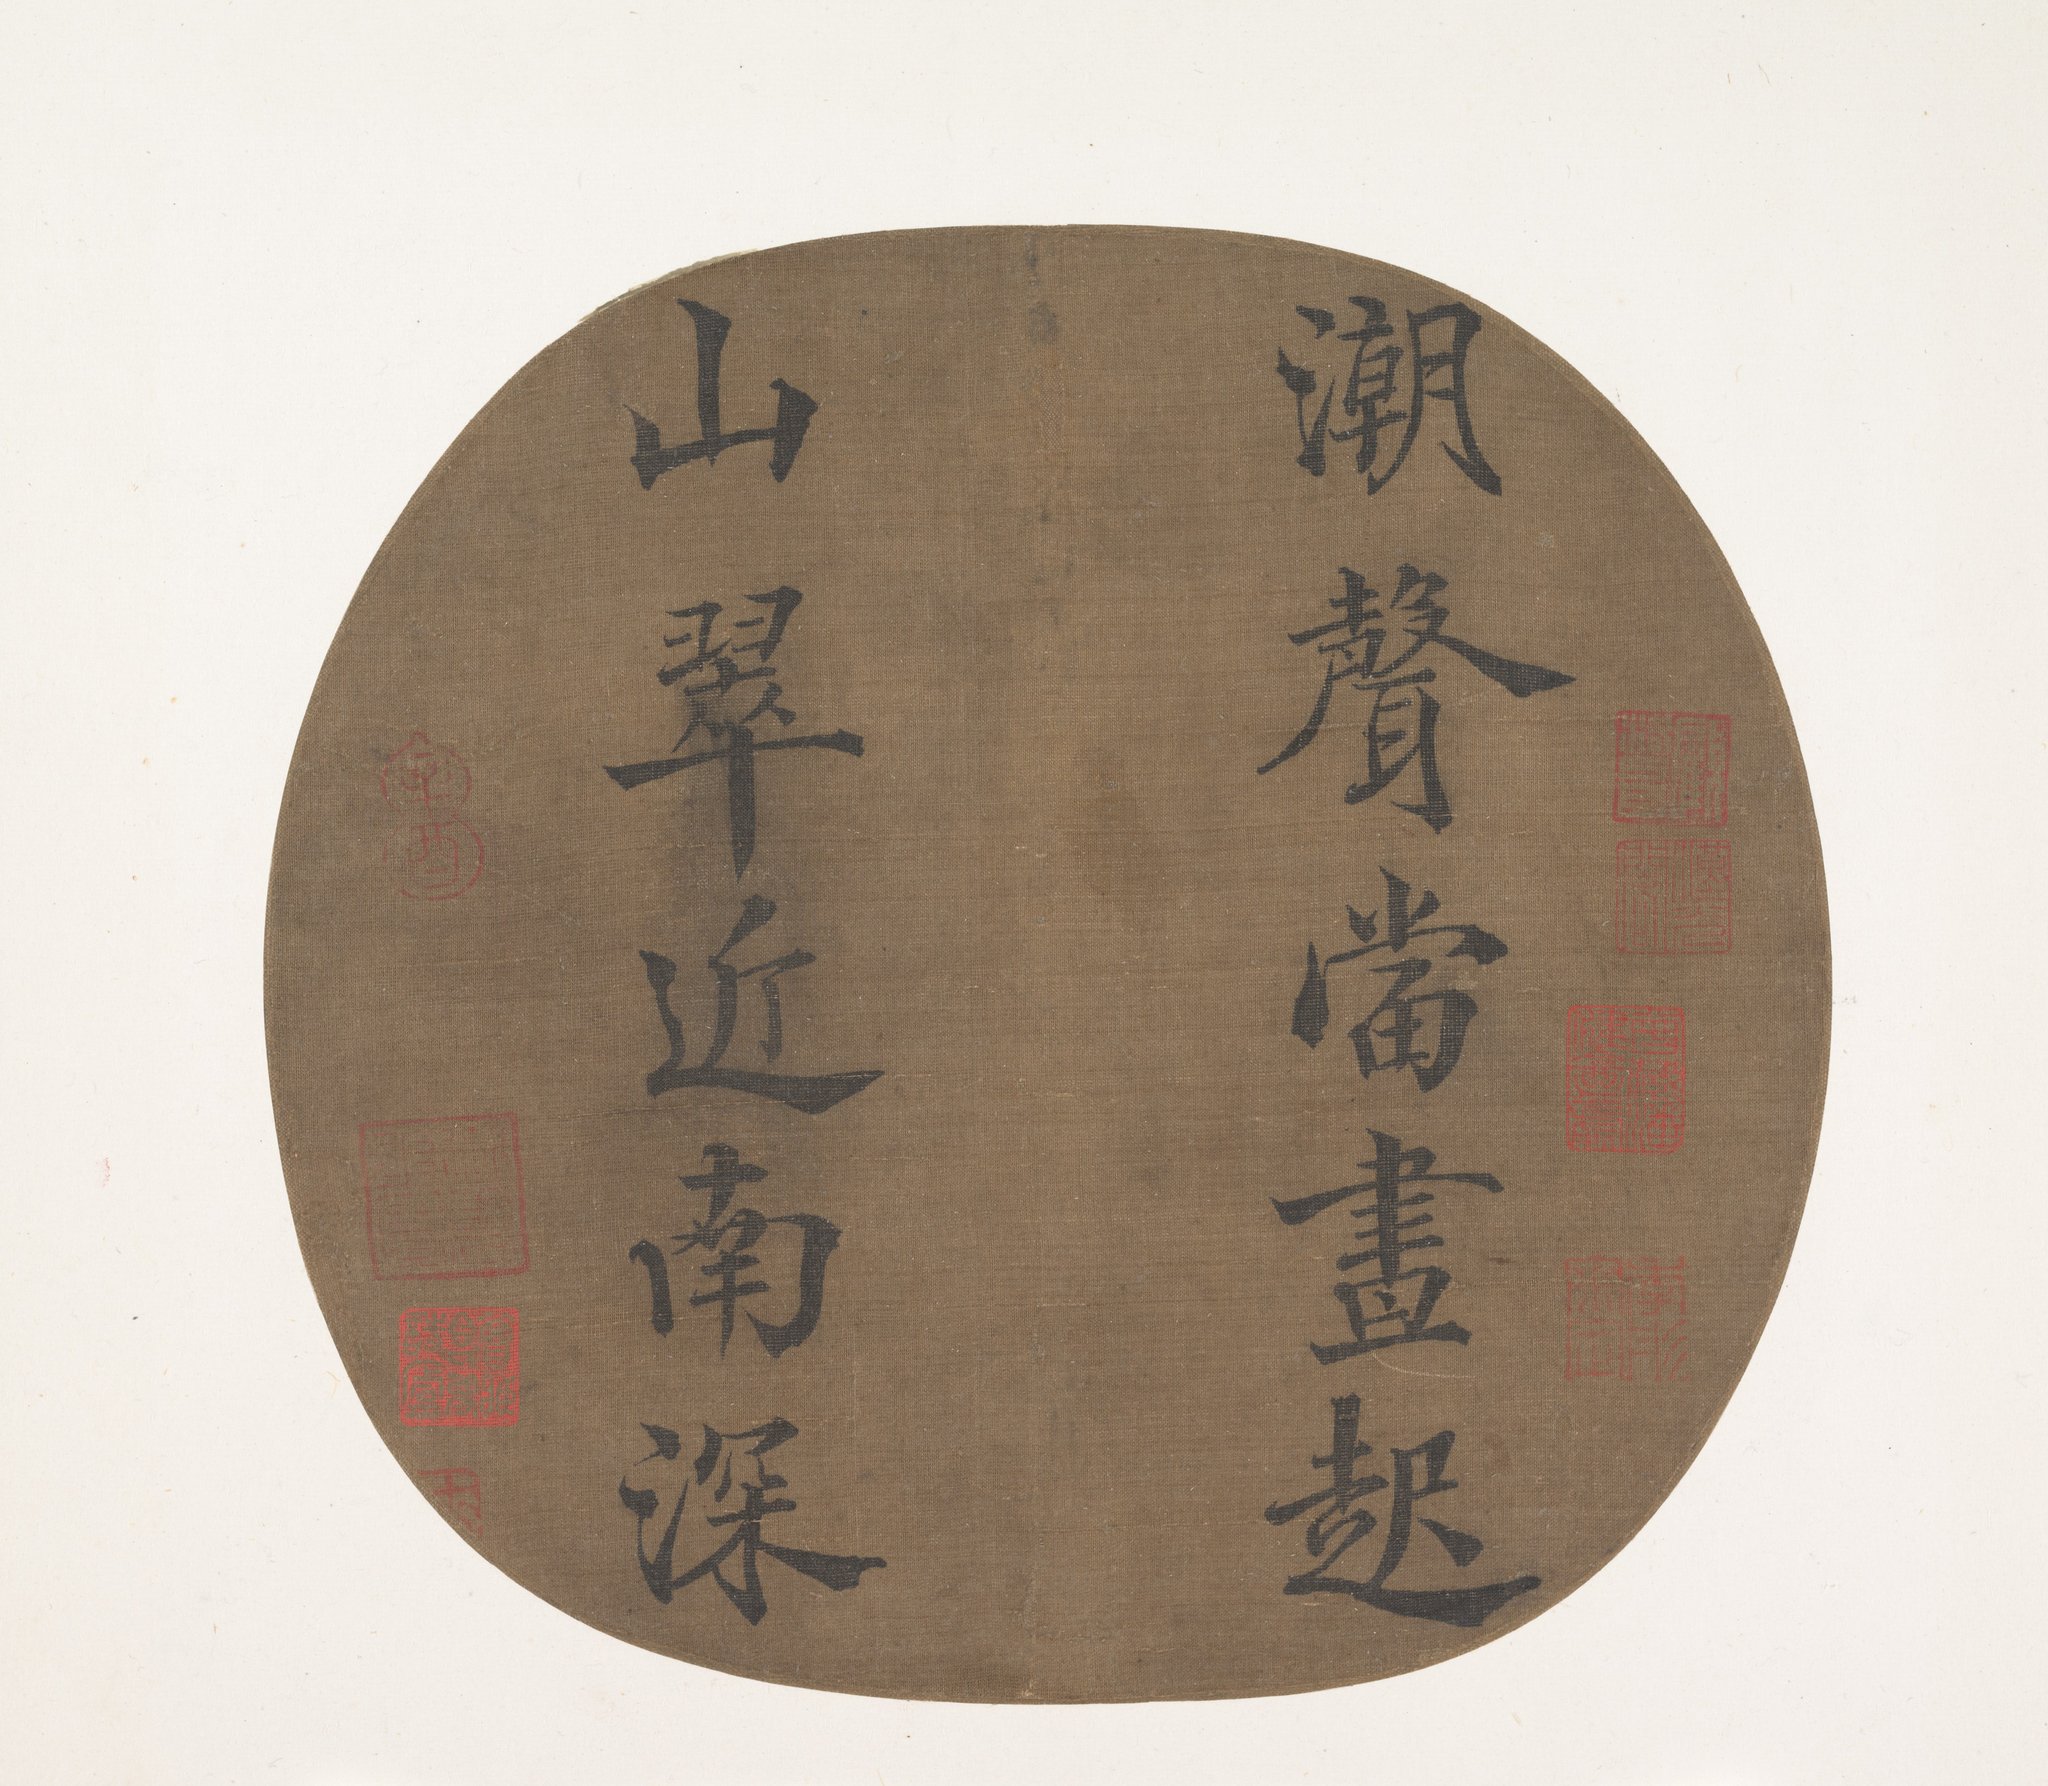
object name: fan mounted a an album leaf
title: Couplet from a Poem by Han Hong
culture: chinese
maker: emperor lizong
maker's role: artist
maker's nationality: chinese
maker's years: 1205-1264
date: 1261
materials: ink, paper, silk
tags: poetry